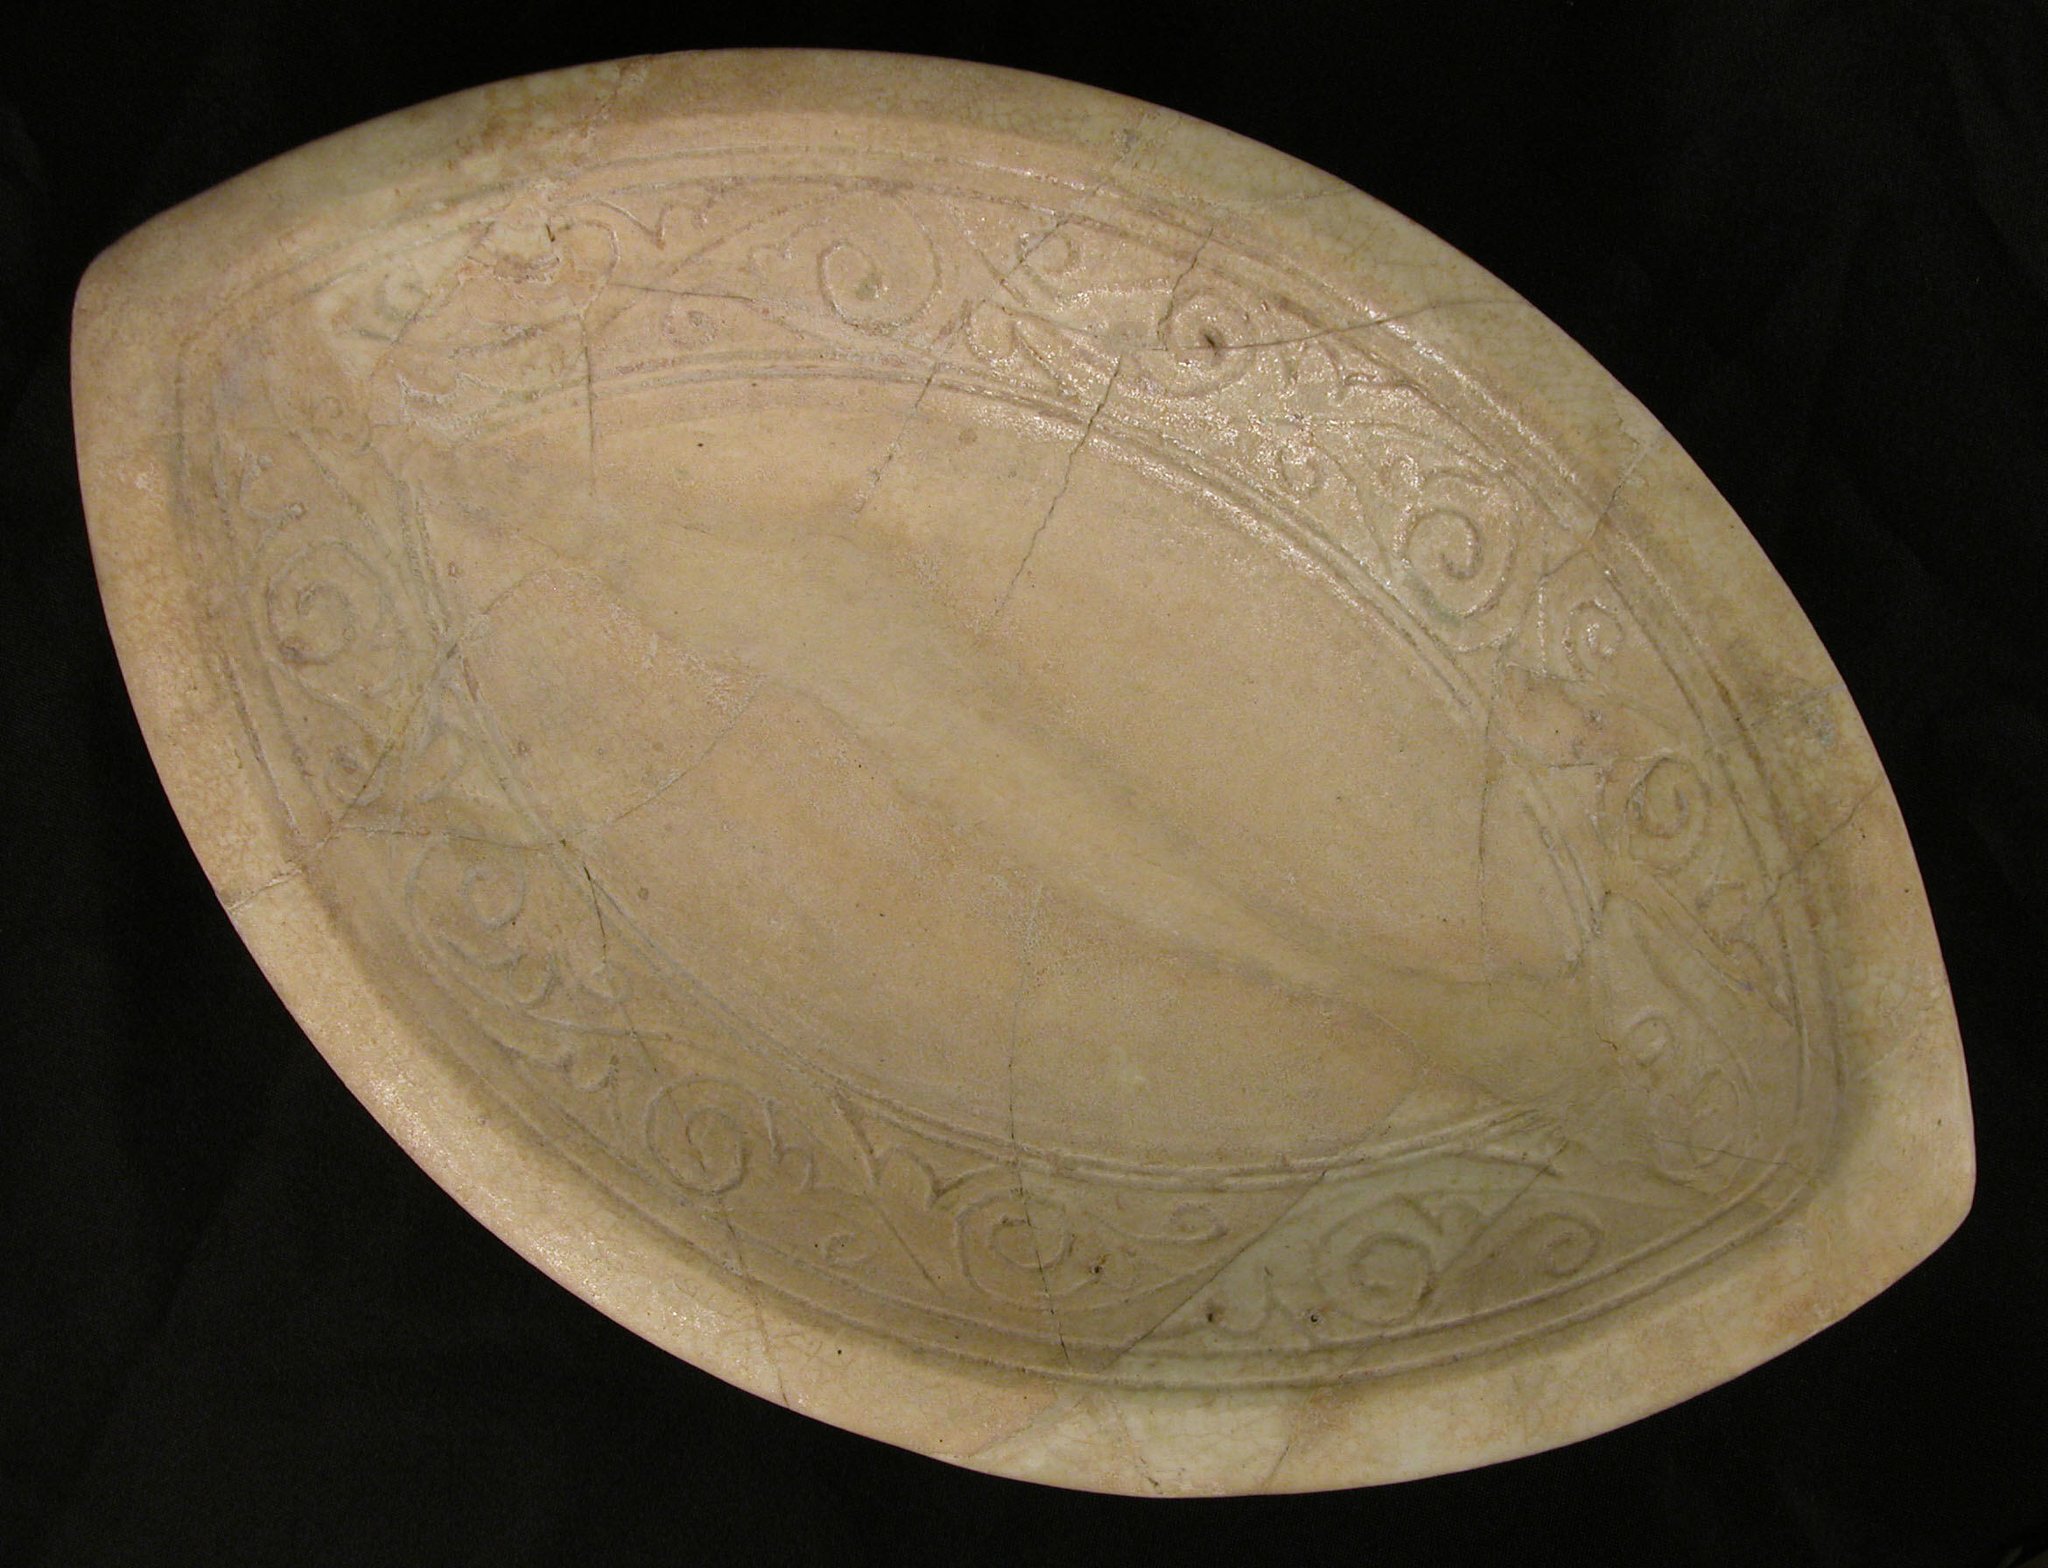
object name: bowl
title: Boat-Shaped Bowl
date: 1067-1200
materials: glaze, stonepaste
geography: iran